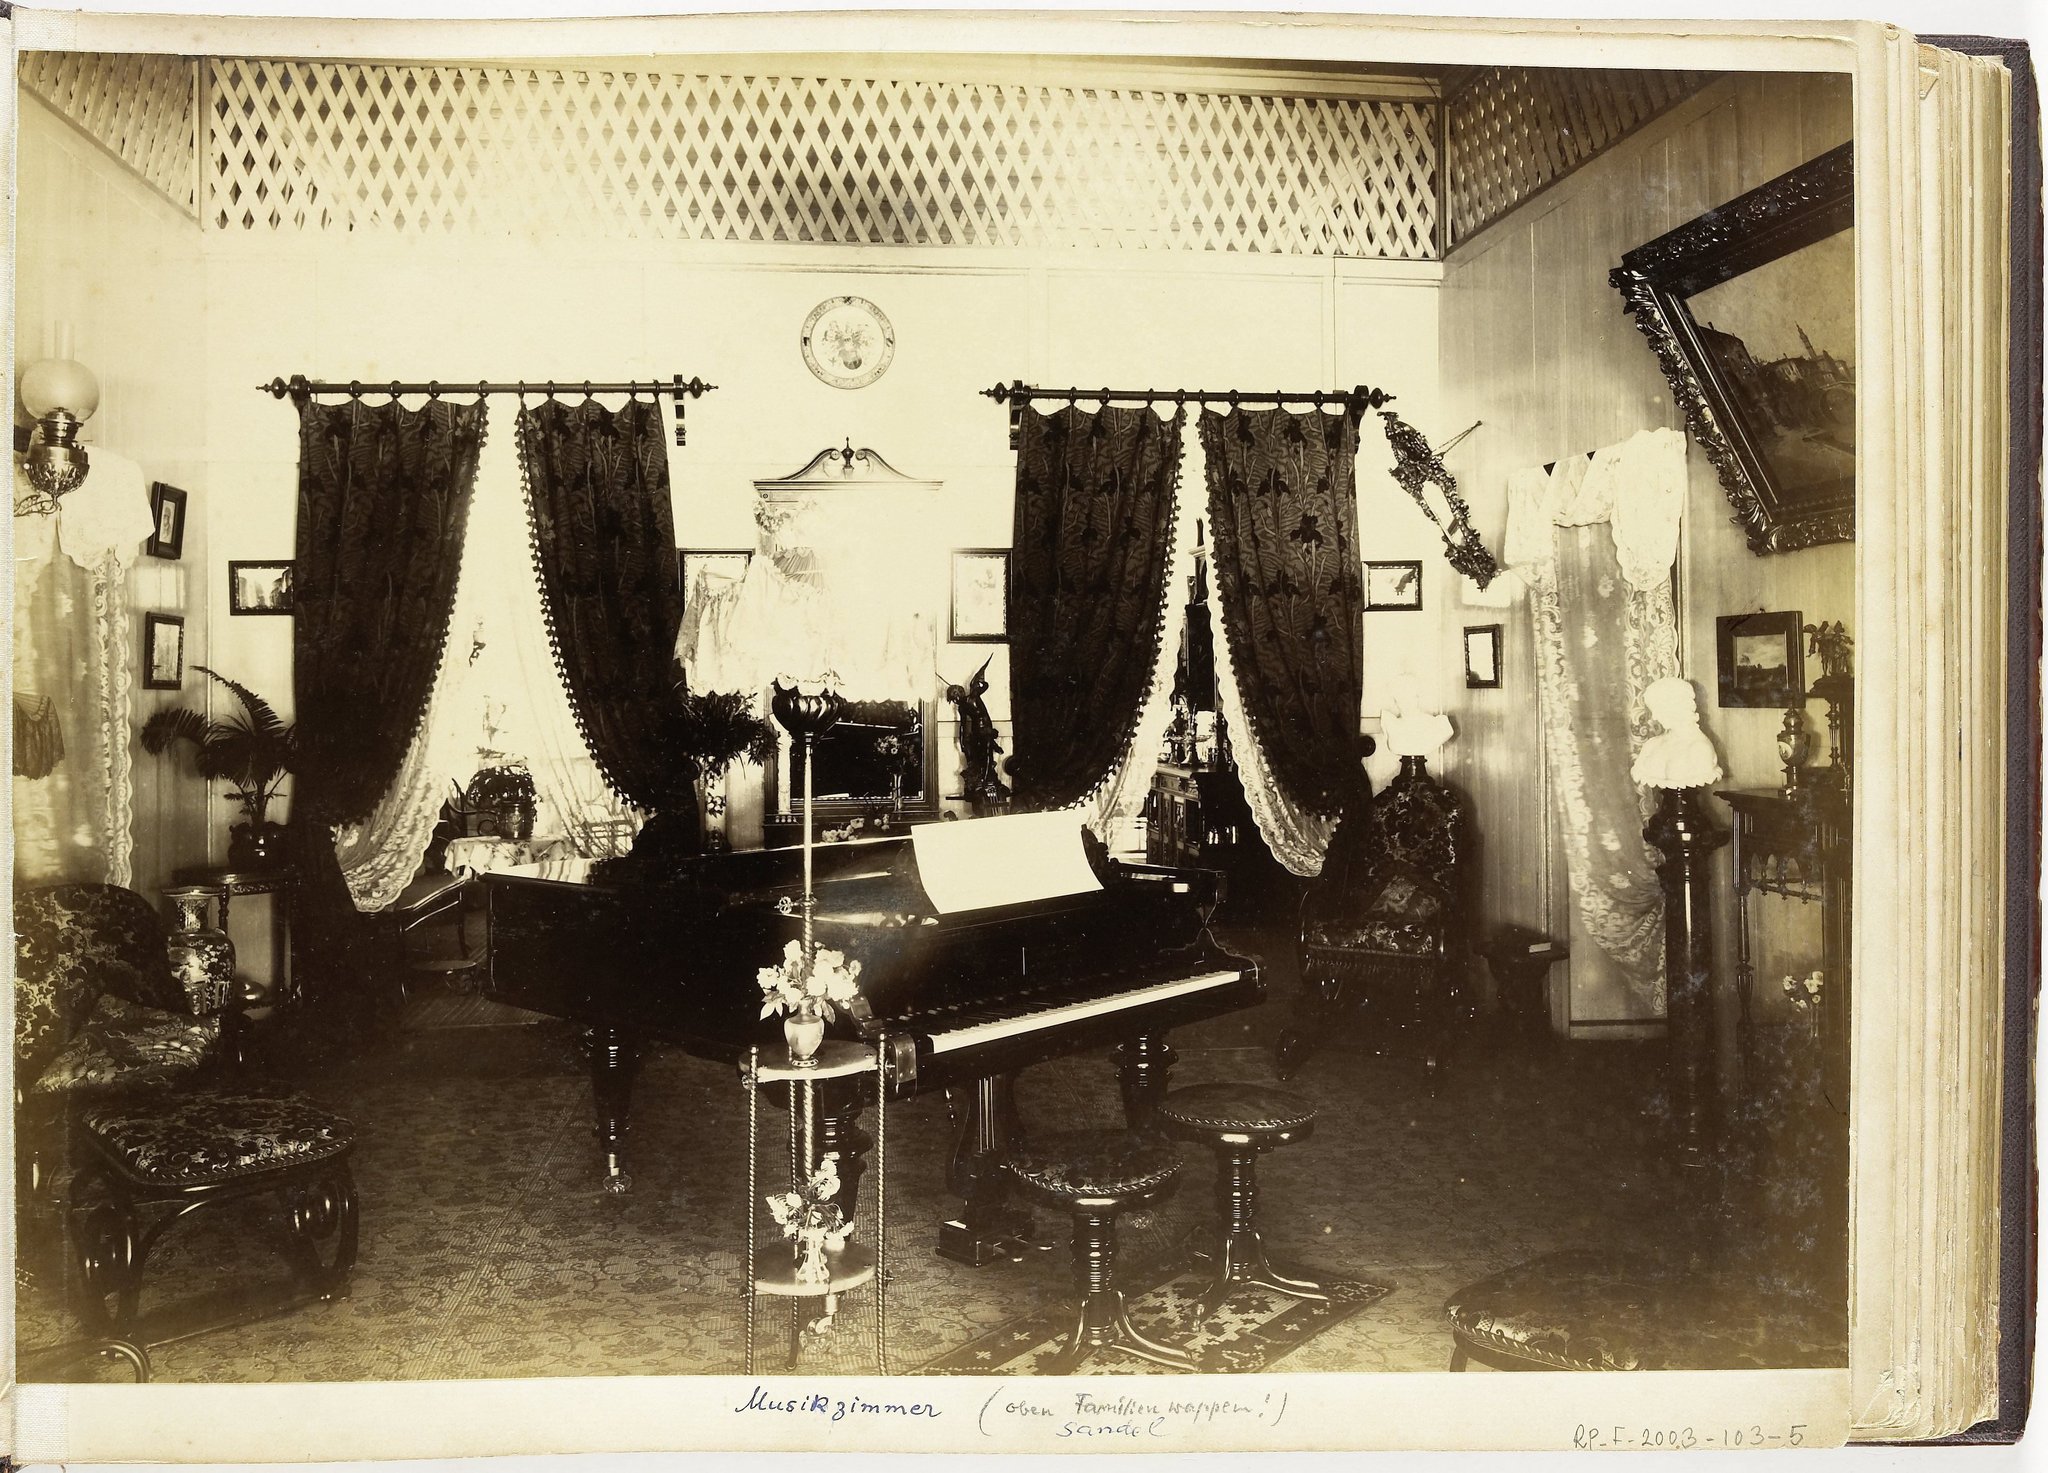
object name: photograph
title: Muziekkamer van het huis van Paul Sandel in Tandjong Poera, Langkat Sumatra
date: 1900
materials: cardboard, paper, photographic support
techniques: albumen print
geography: bindjai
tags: tandjong poera